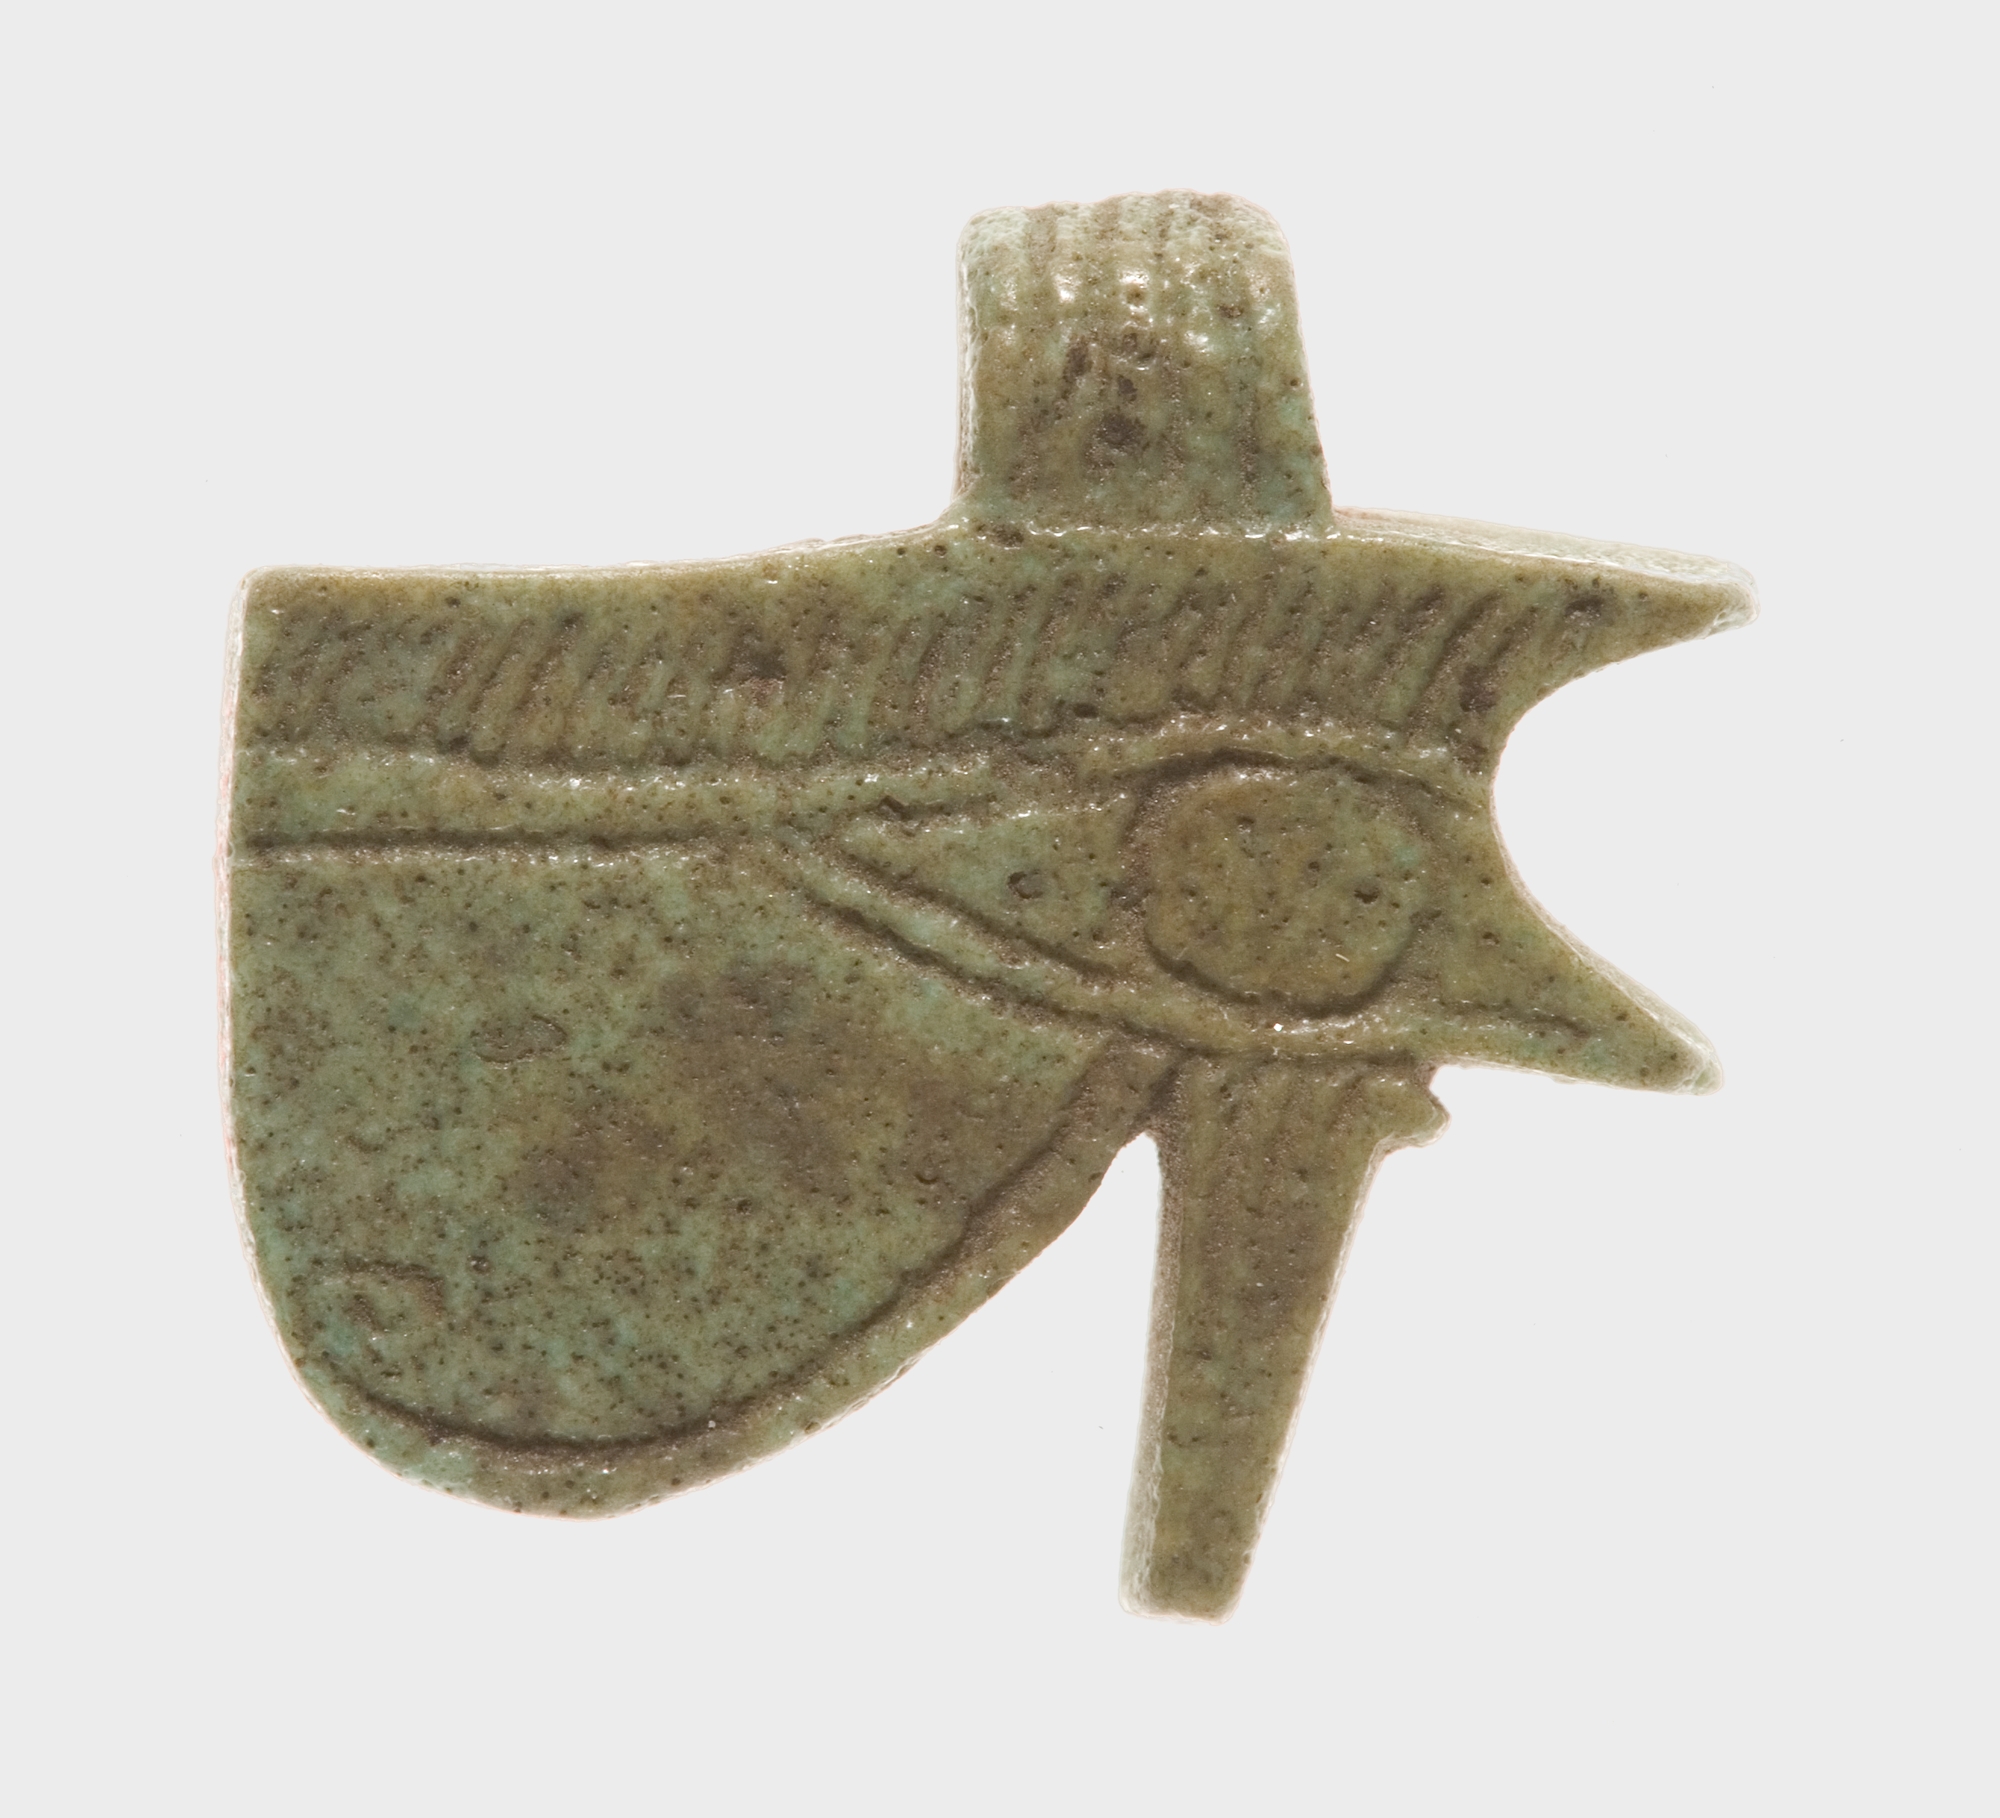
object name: amulet, wedjat eye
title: Wedjat eye amulet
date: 1070-664 BCE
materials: faience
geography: egypt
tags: eyes